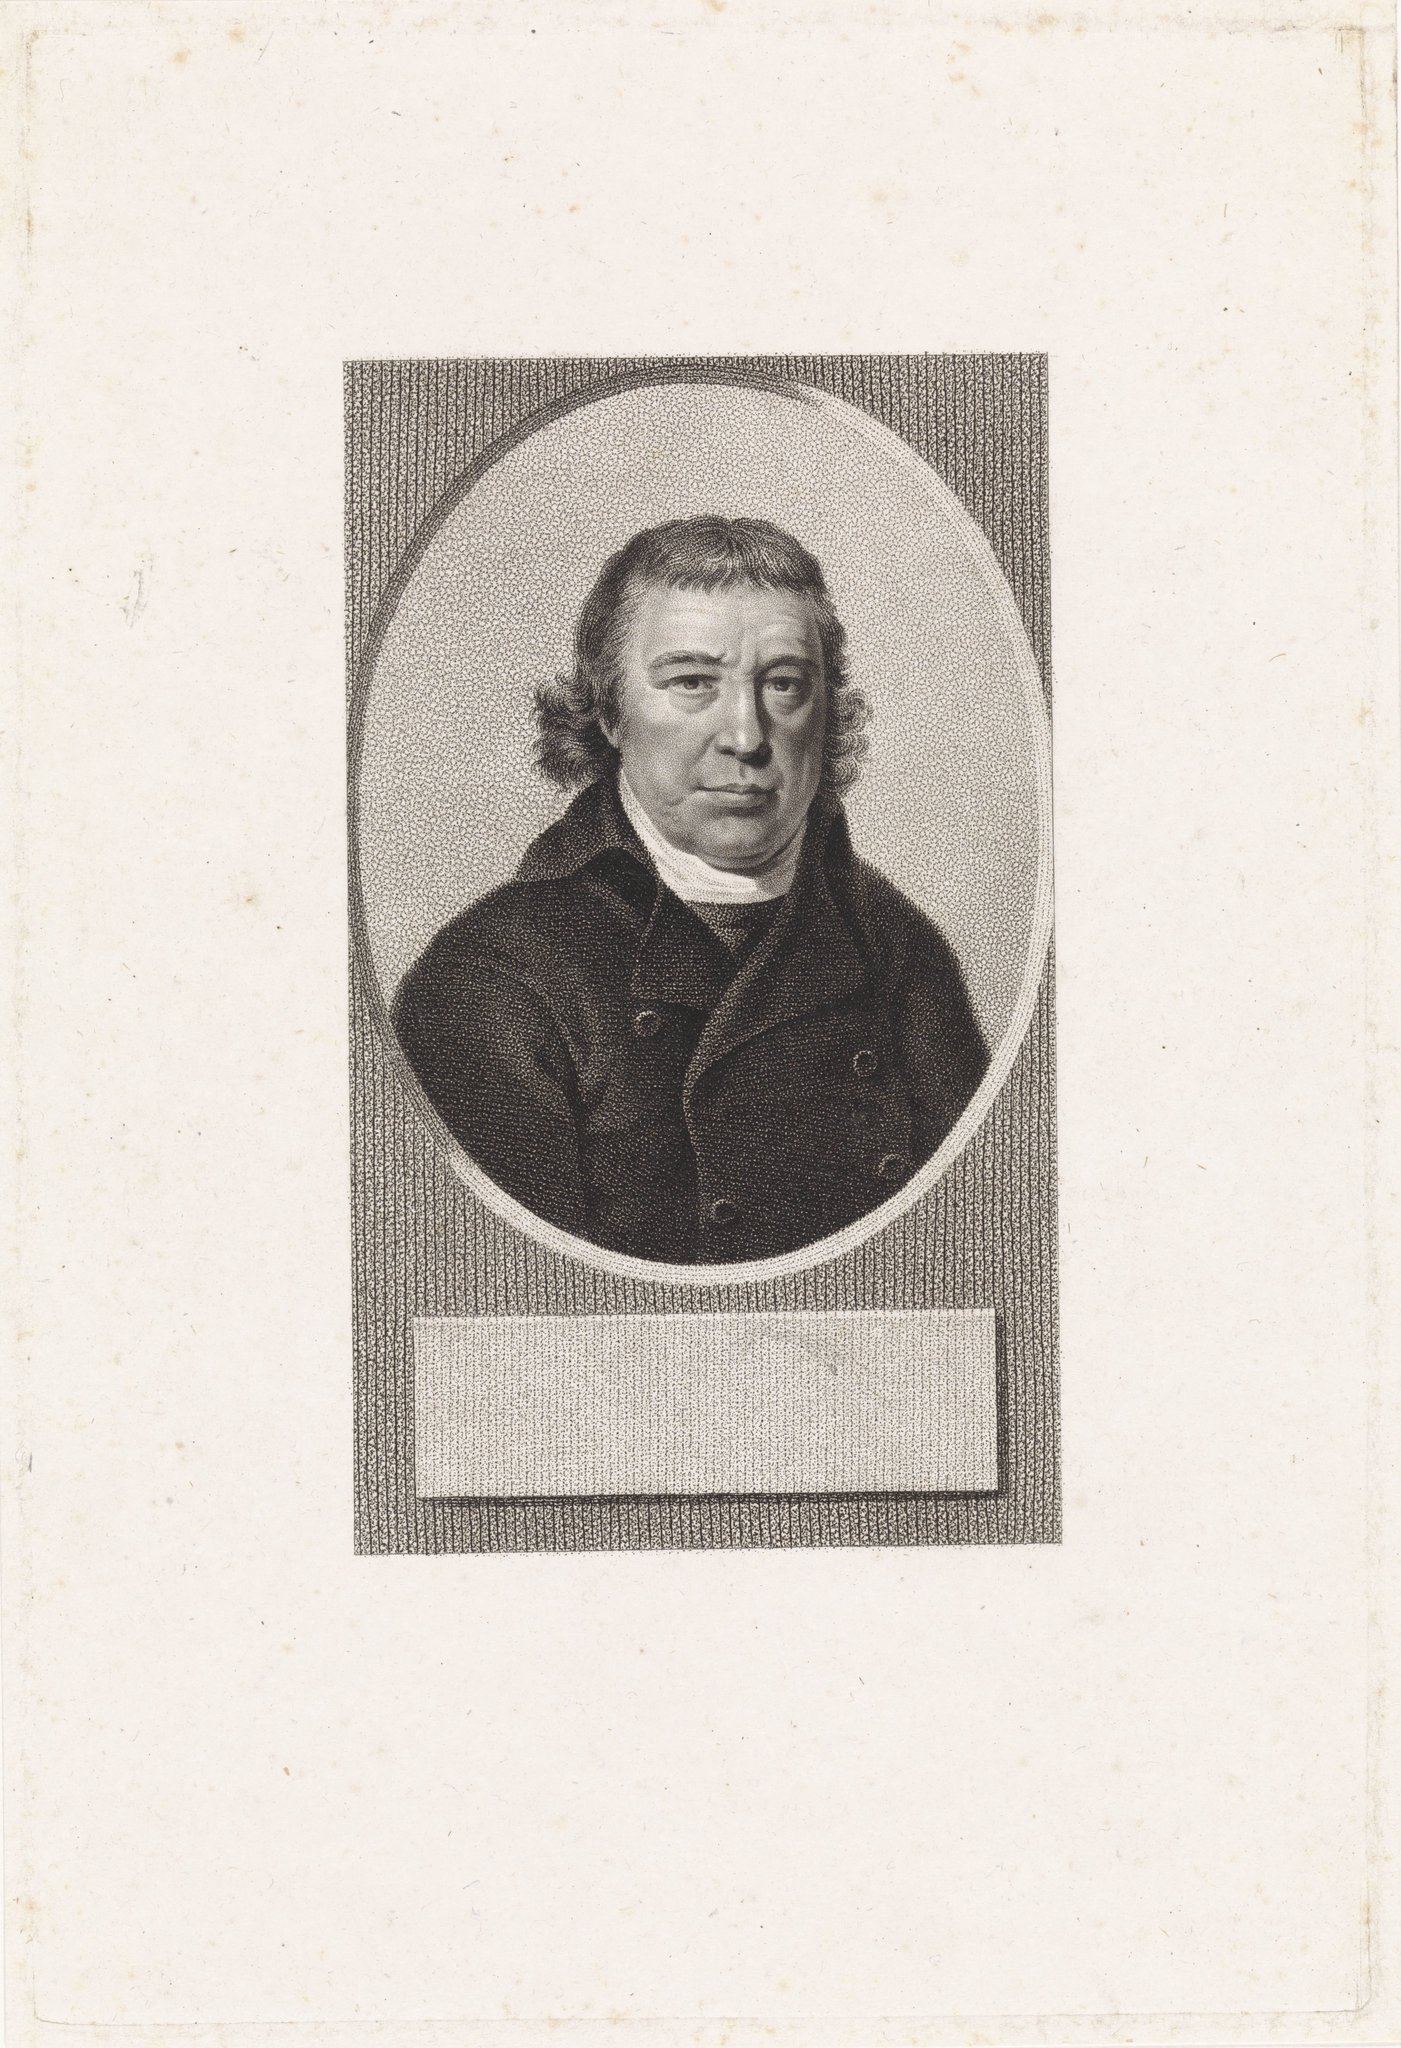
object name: print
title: Portret van de rechtsgeleerde Adolph Ypeij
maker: ludwig gottlieb portman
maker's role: print maker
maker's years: 1772-1828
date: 1804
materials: paper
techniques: etching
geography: amsterdam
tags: leeuwarden, adolph ypeij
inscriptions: collector's mark: Lugt 2228